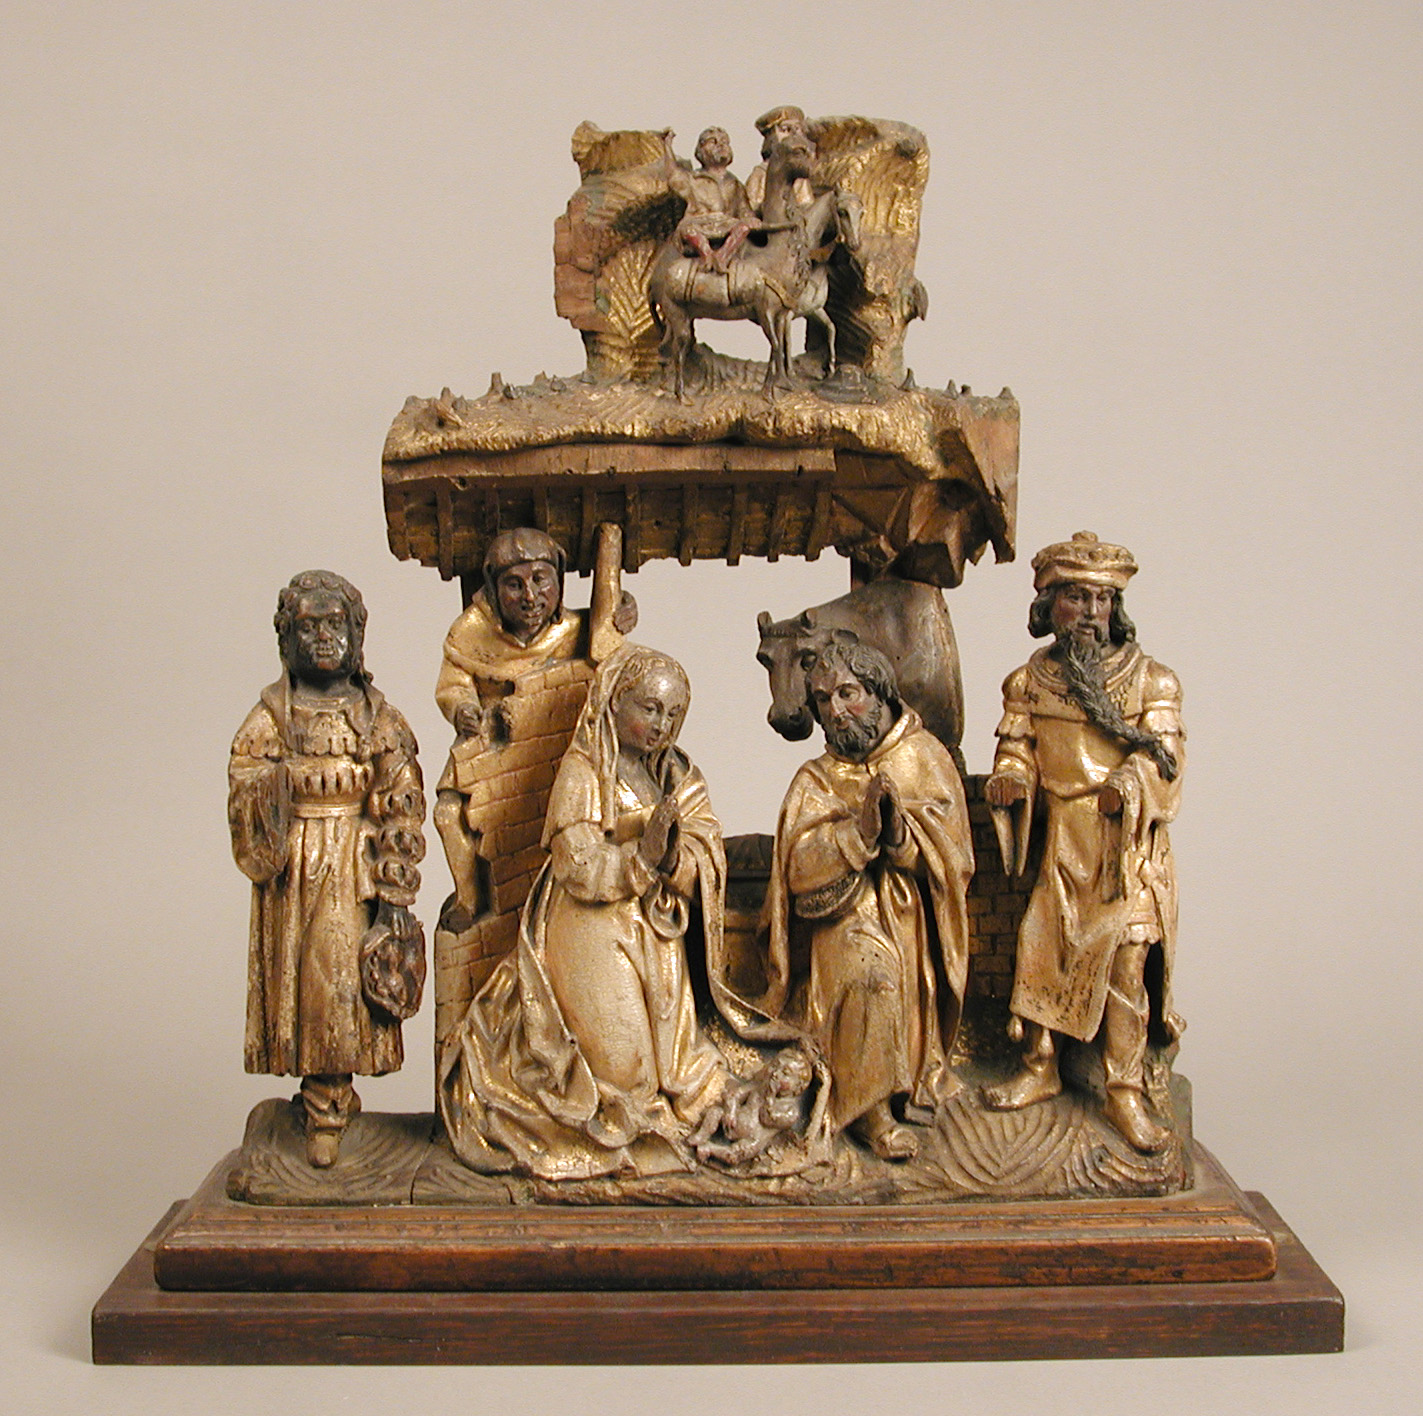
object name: relief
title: Adoration of the Magi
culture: south netherlandish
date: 1520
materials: wood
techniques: gilding, polychromy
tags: donkeys,christ,virgin mary,adoration of the magi